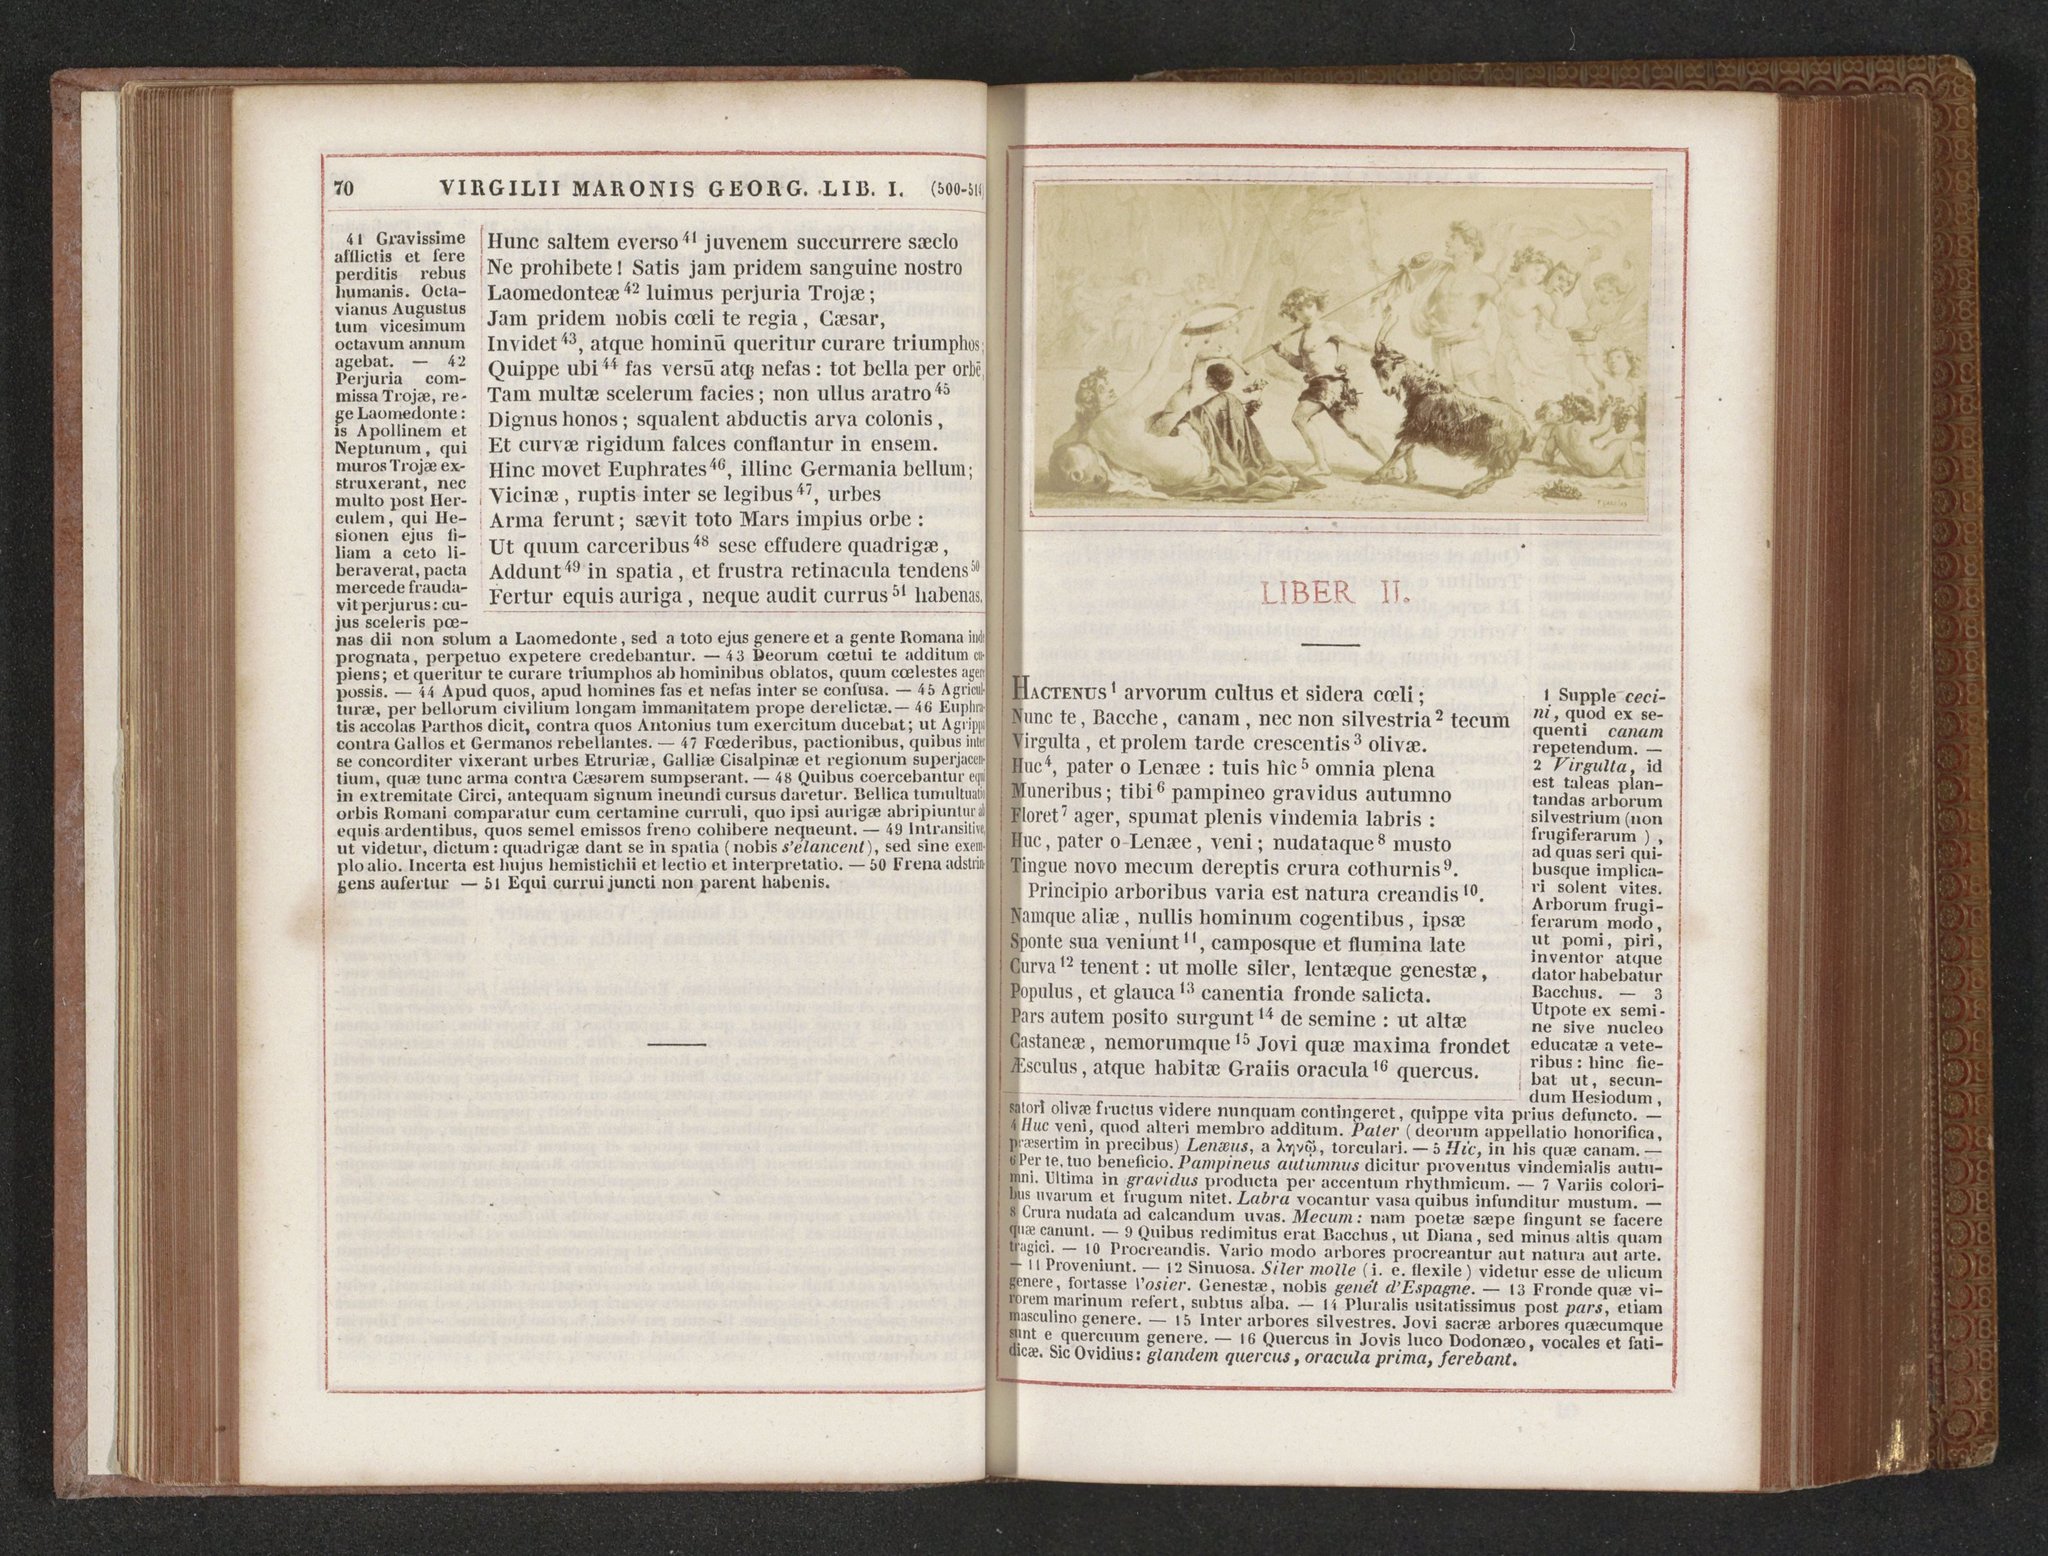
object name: photograph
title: Fotoreproductie van een schilderij, voorstellende een optocht met een liggende, naakte vrouw en een jongen met een geit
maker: Anonymous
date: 1850-1858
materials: photographic support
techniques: albumen print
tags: woman (showing herself) undressed, quasi-nude, goat